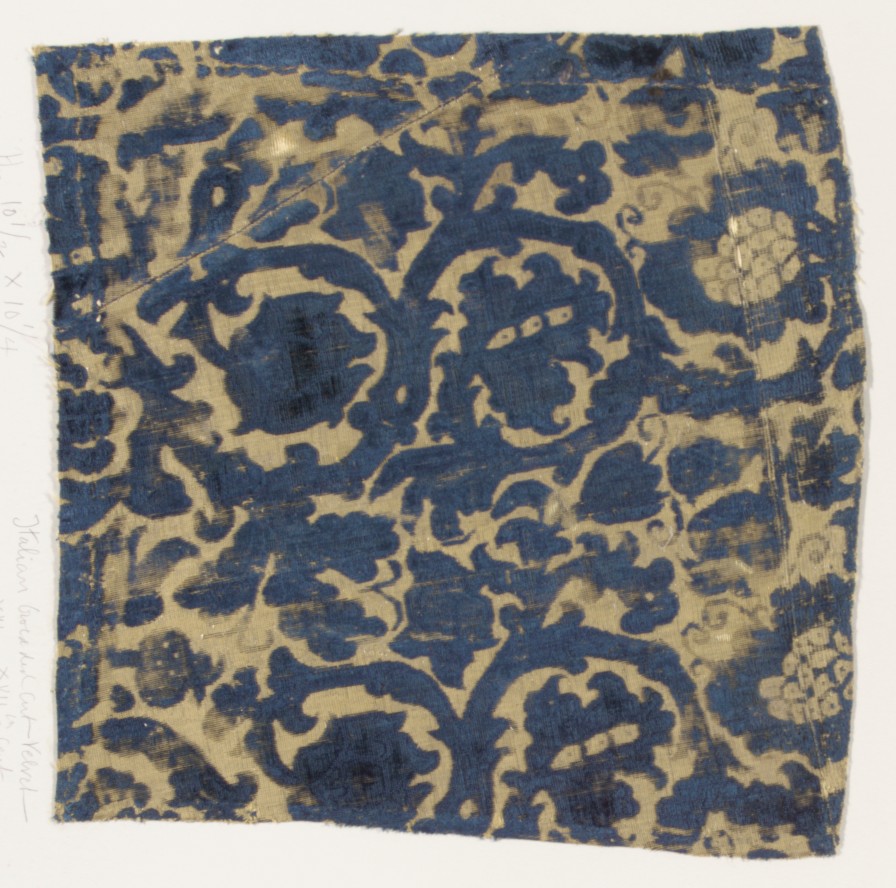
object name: fragment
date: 1501-1700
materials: metal thread, silk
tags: leaves